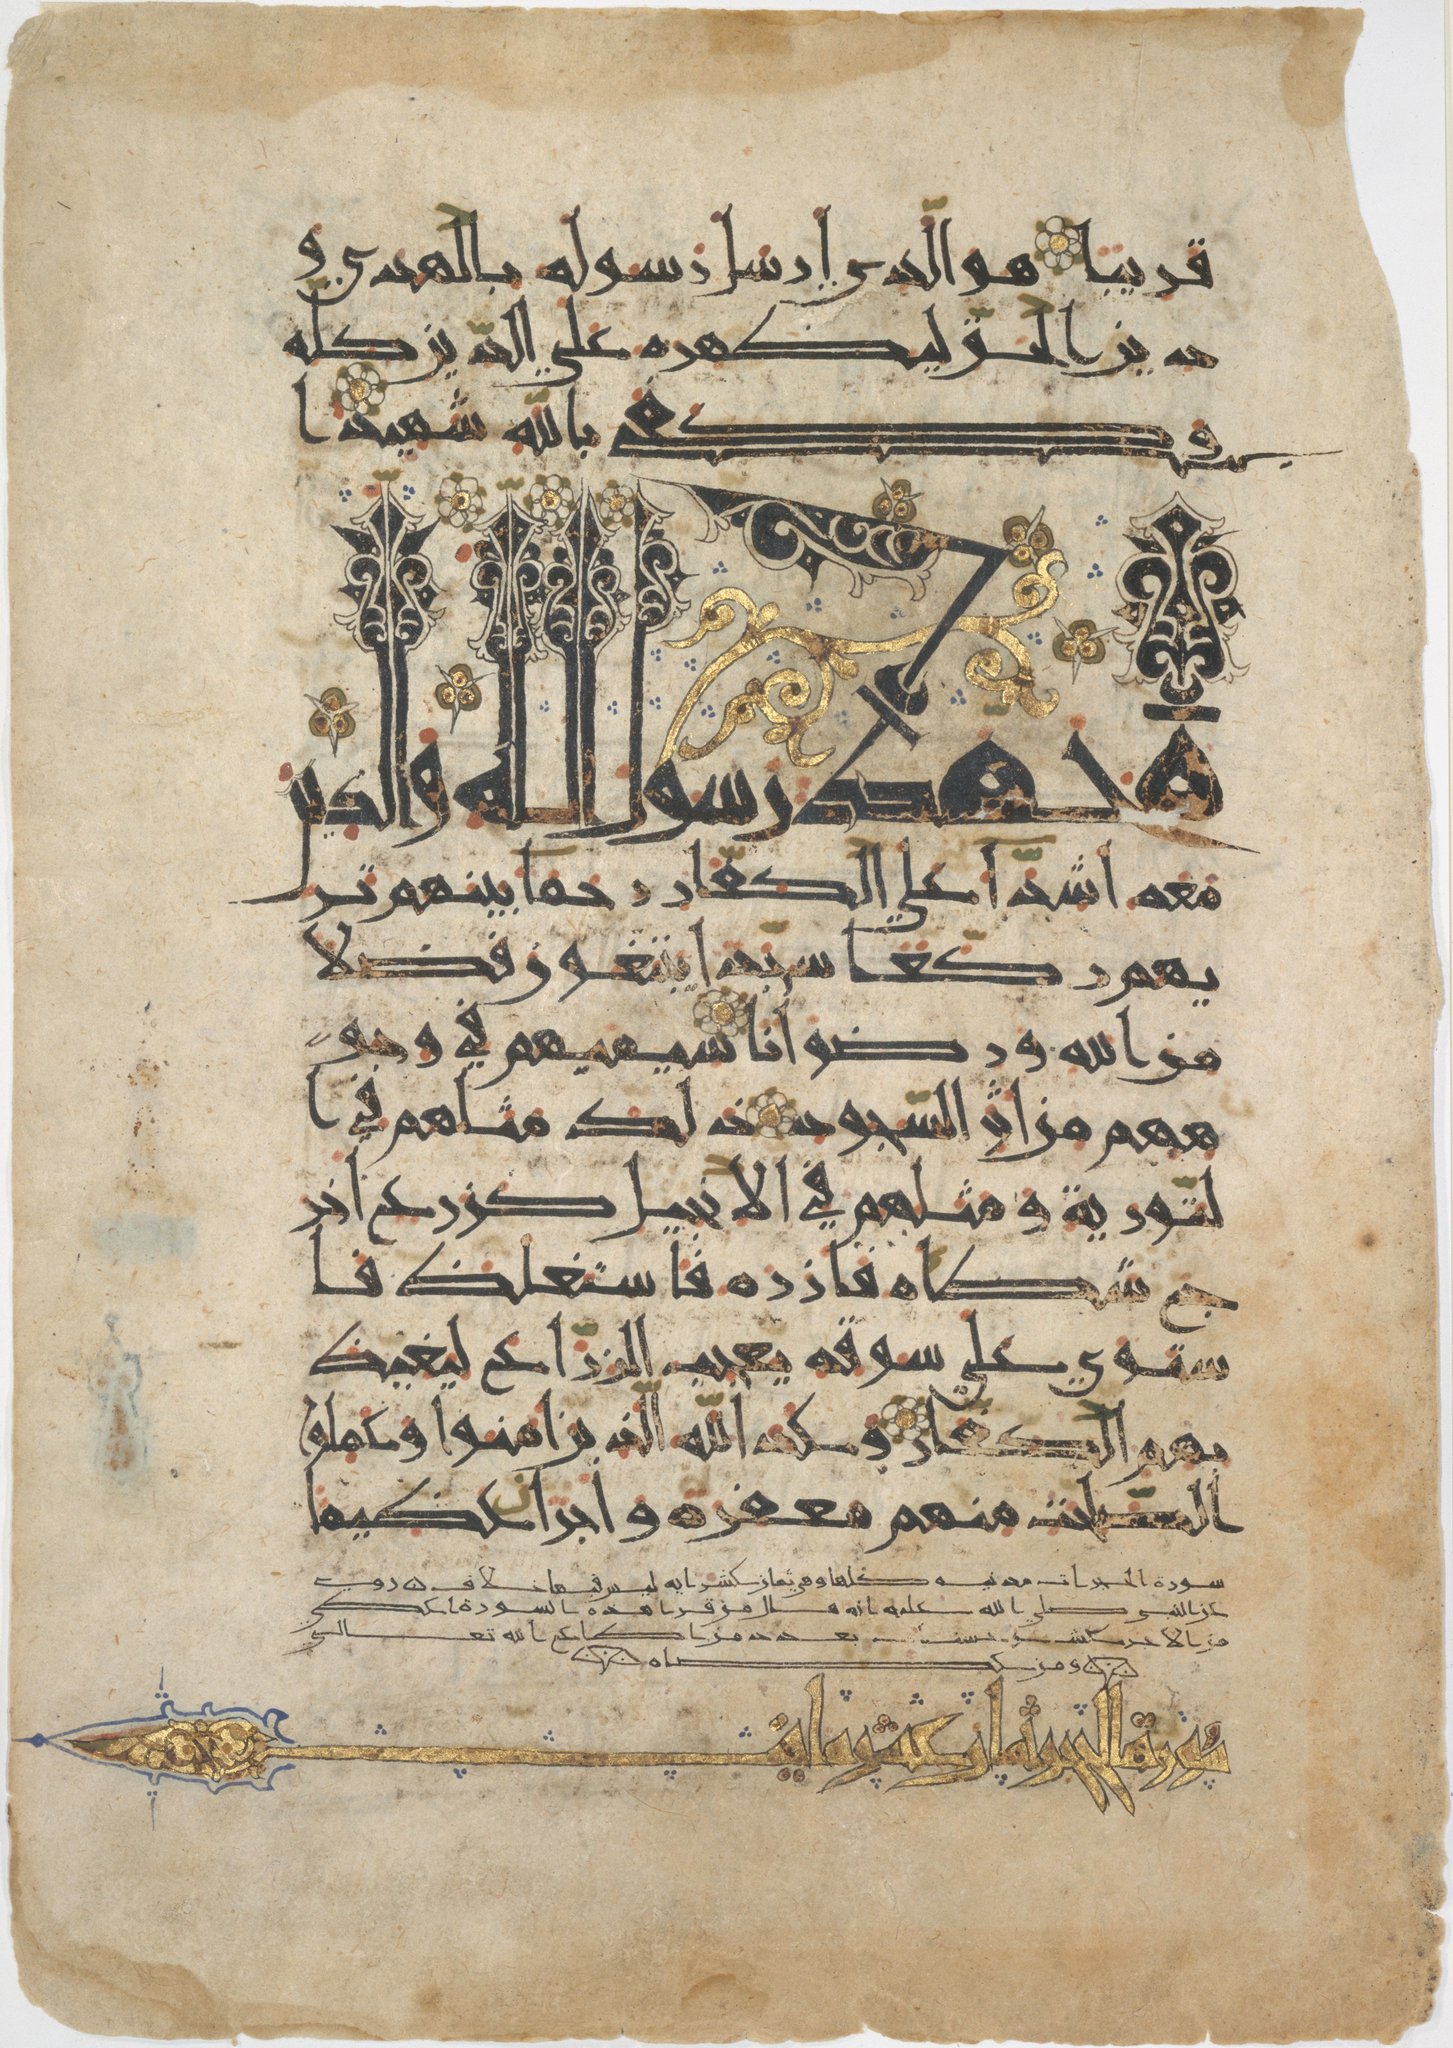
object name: folio from a non illustrated manuscript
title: Folios from a Qur'an Manuscript in Floriated "New Style" Script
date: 1001-1100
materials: gold, ink, paper, watercolor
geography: iran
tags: qur'an,calligraphy